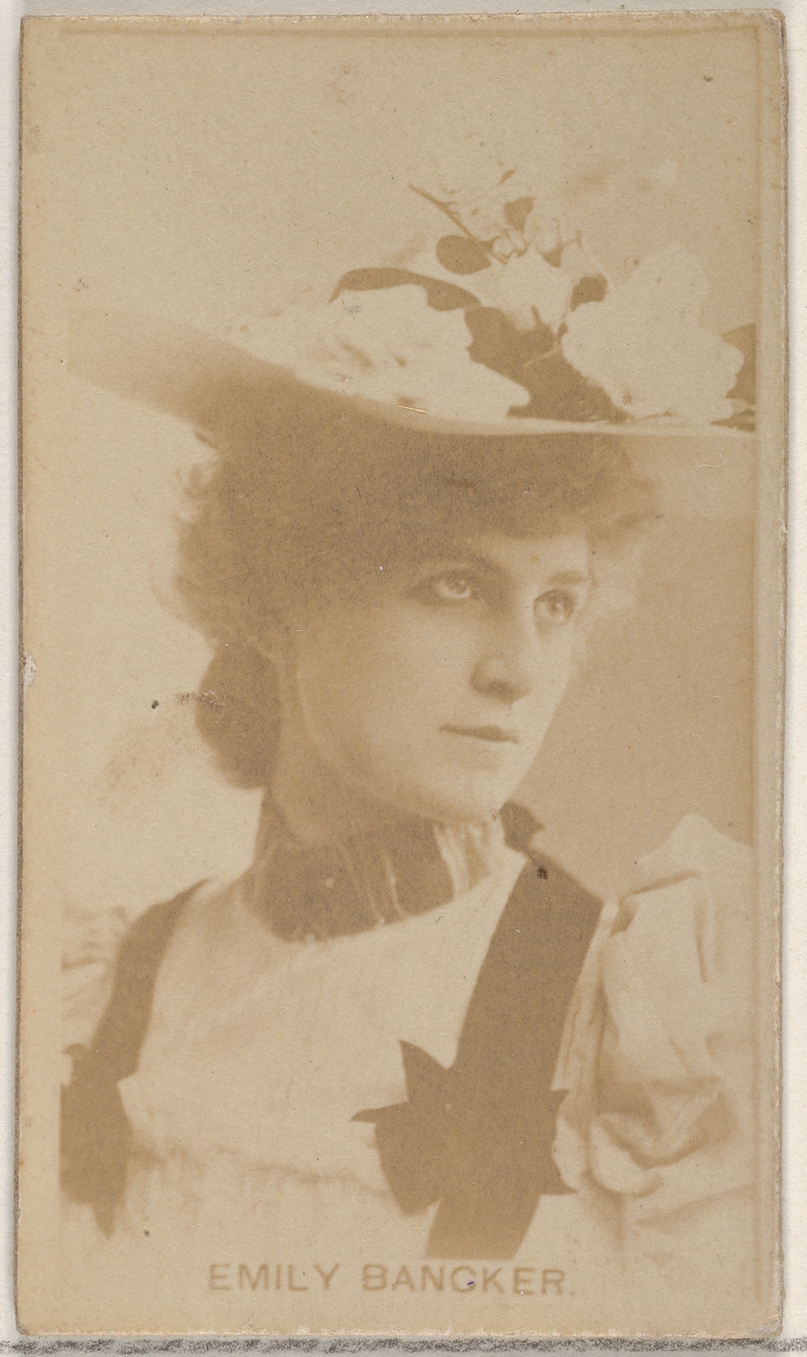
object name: photograph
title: Emily Bancker, from the Actors and Actresses series (N45, Type 8) for Virginia Brights Cigarettes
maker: allen & ginter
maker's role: publisher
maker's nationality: american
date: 1888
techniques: albumen silver print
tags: portraits,women,actresses